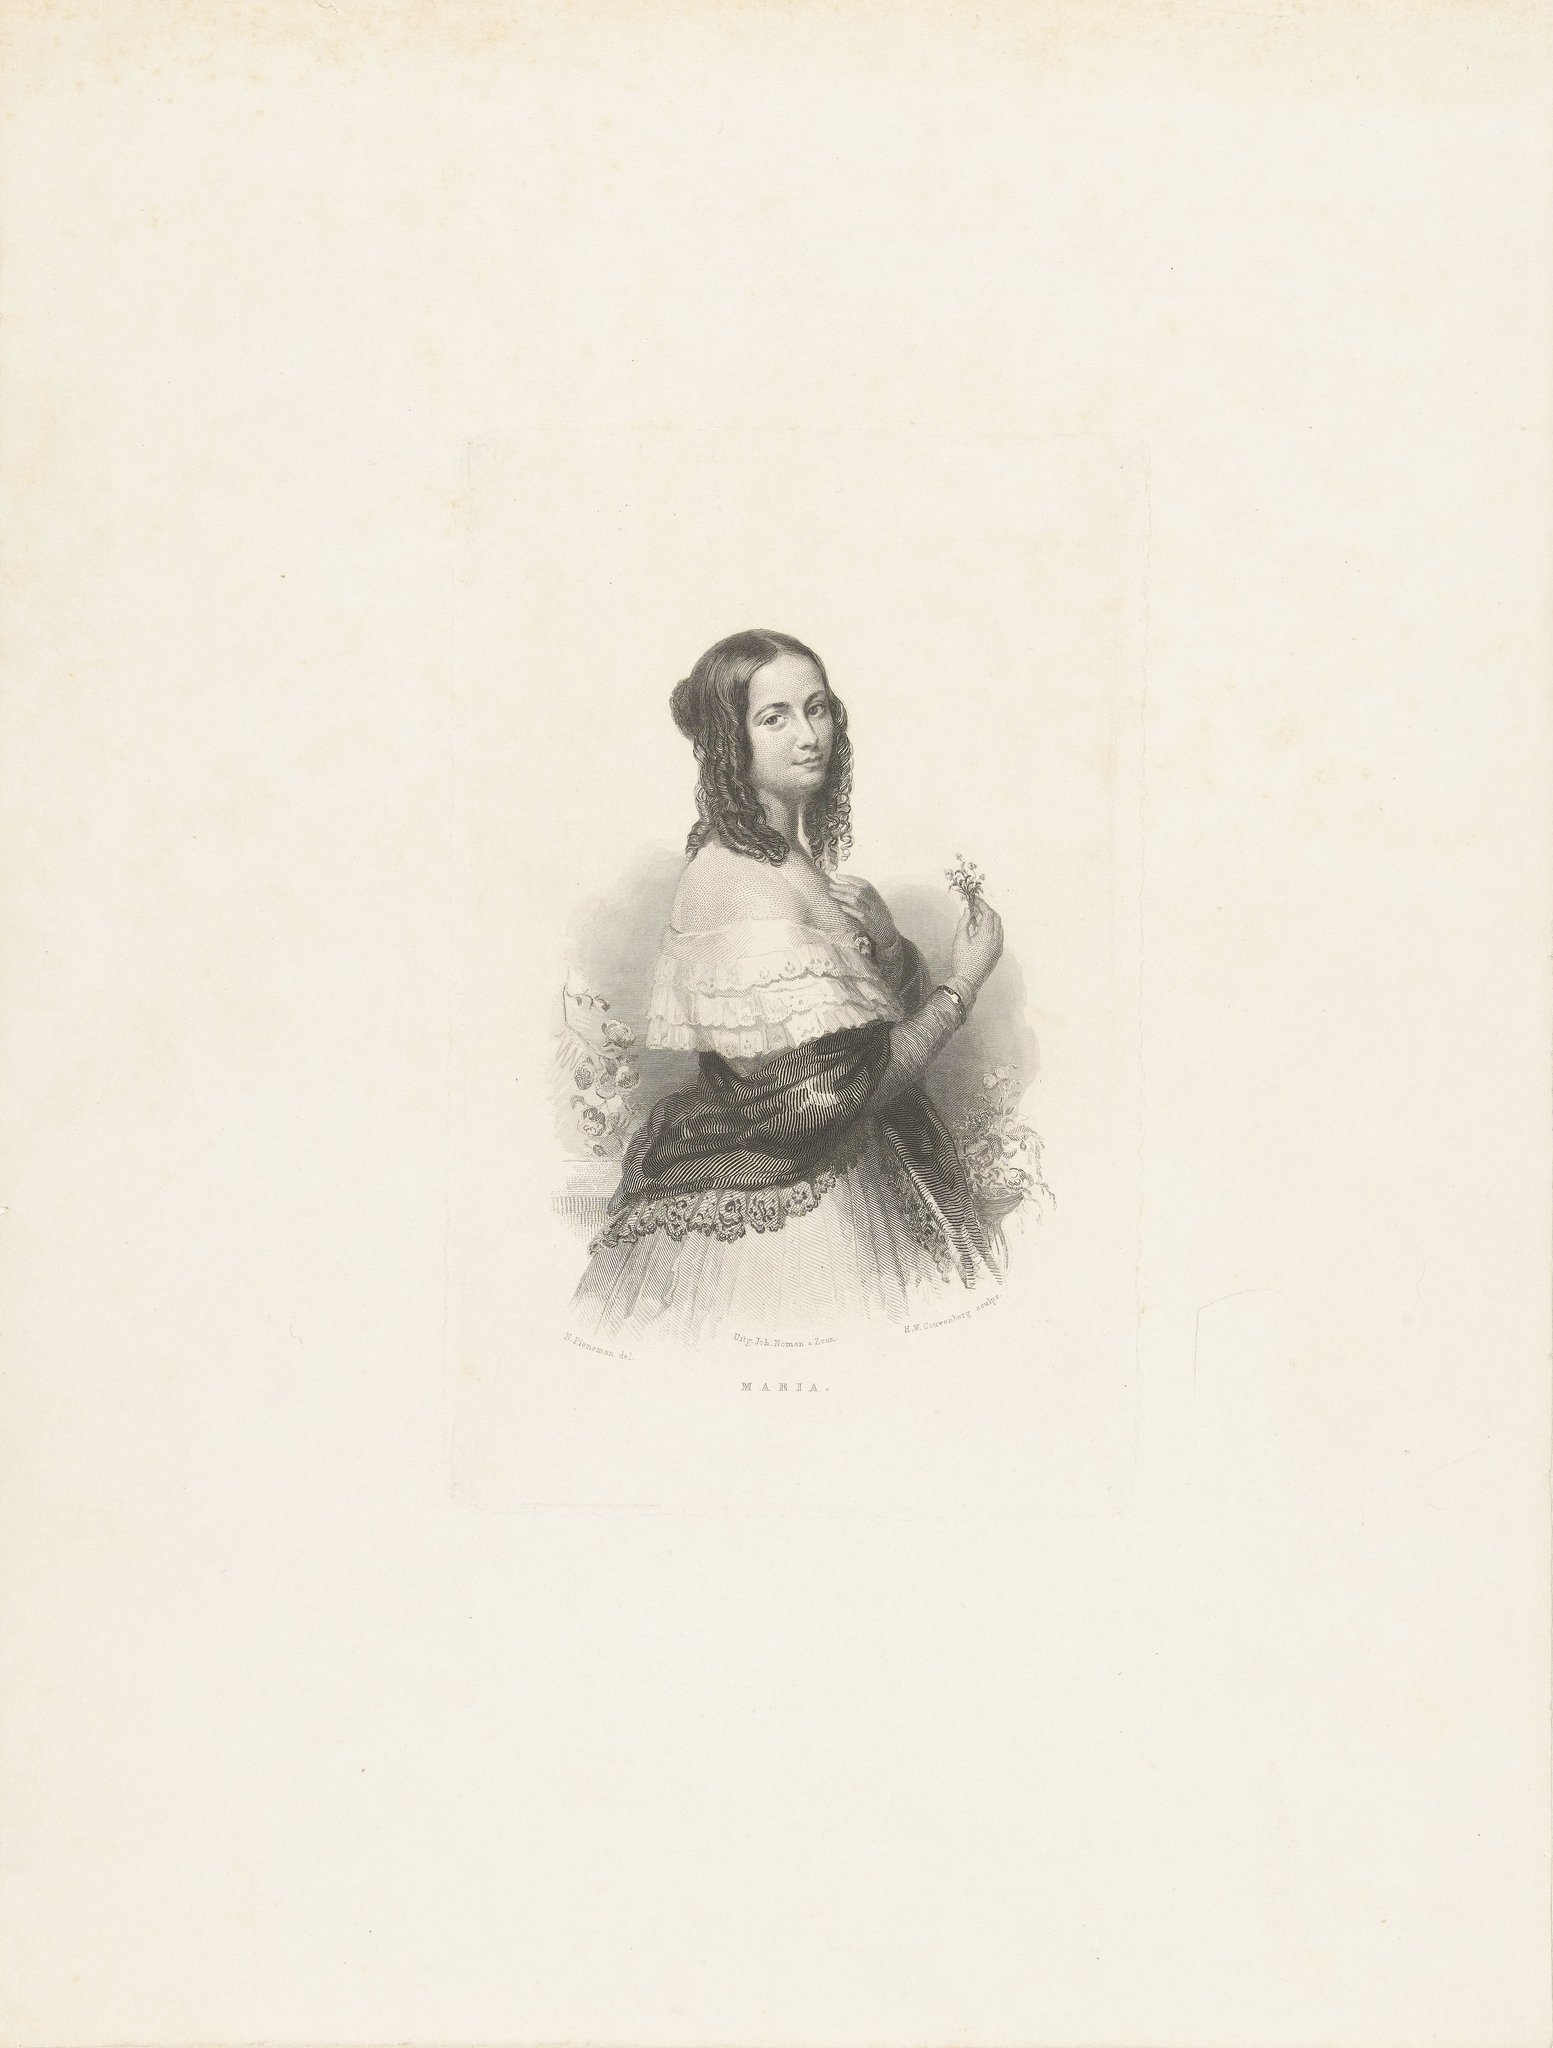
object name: print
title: Portret van een jonge dame met een boeketje in haar handen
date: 1830-1845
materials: paper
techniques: engraving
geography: zaltbommel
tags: historical persons not known by name - bb - woman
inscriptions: collector's mark: Lugt 2228